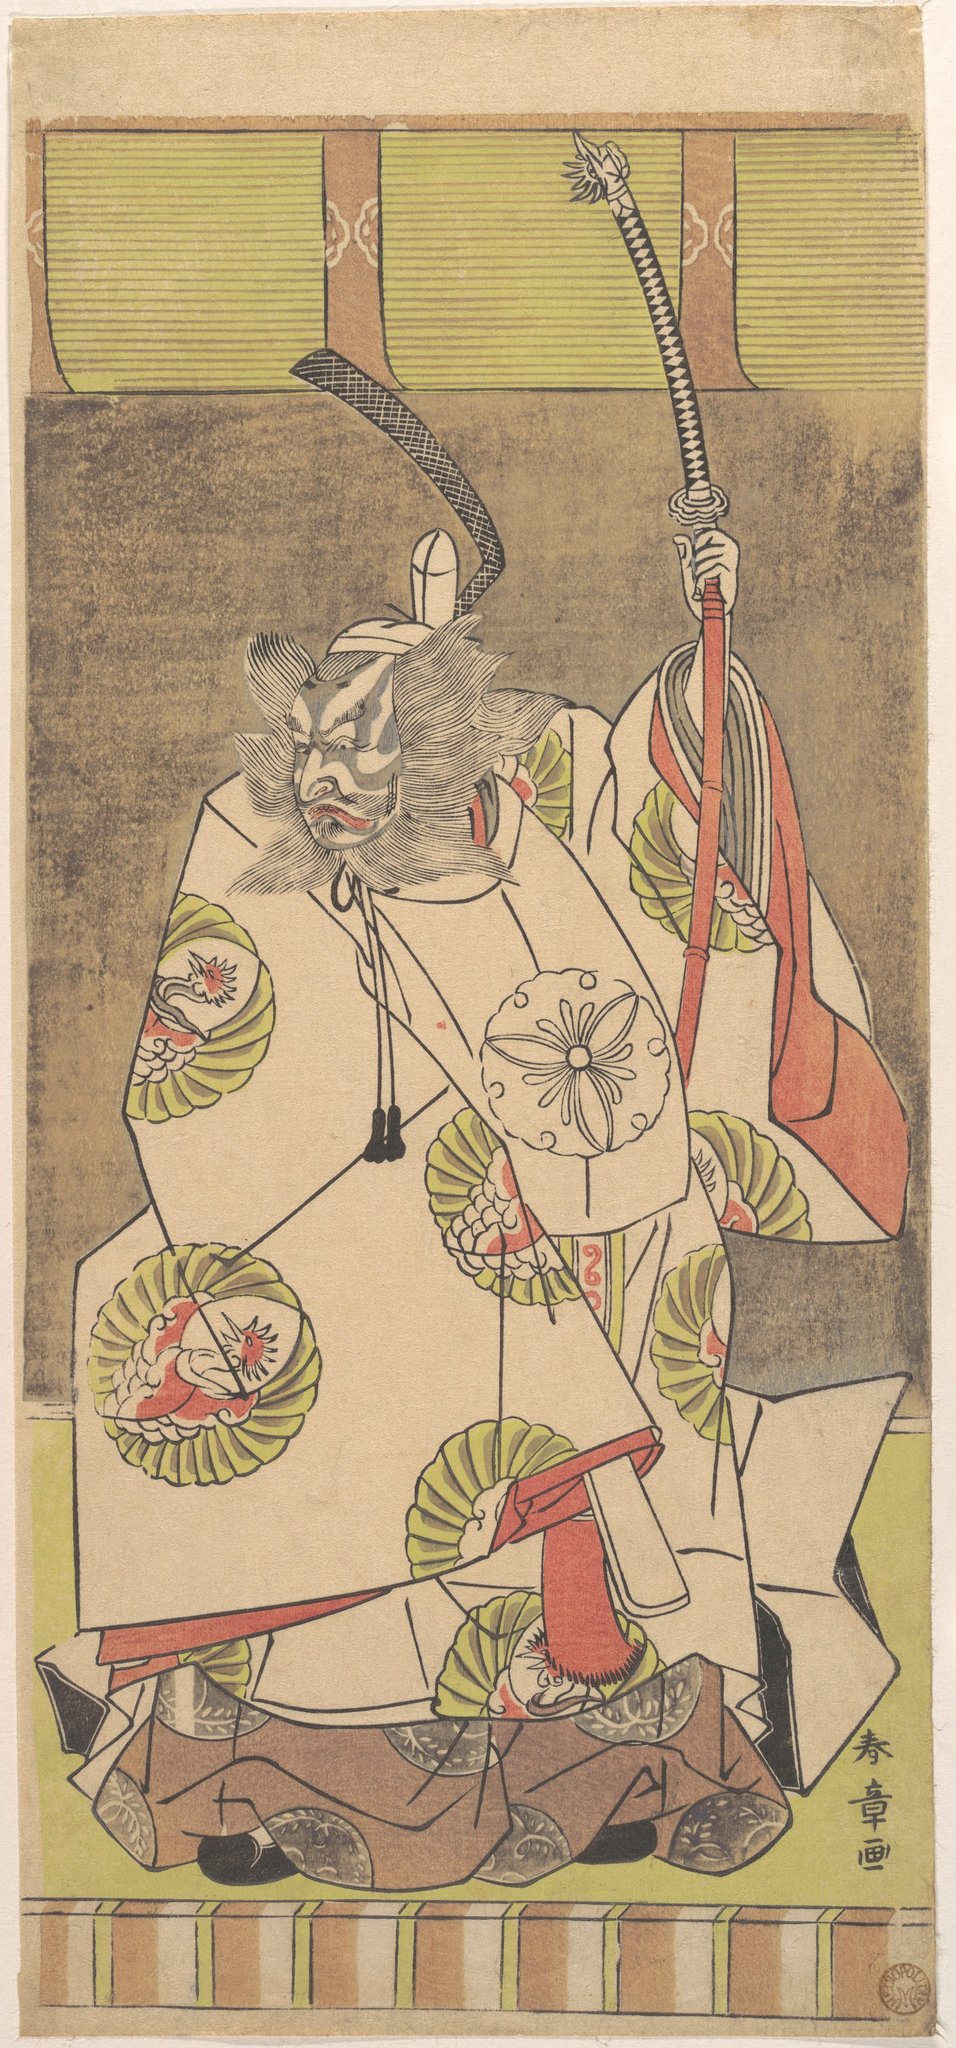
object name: woodblock print nishiki e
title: Kabuki Actor Ichikawa Danjūrō IV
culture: japanese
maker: katsukawa shunshō 勝川春章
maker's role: artist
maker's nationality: japanese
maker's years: 1726-1792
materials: ink, paper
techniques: nishiki e, woodblock print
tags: men,actors